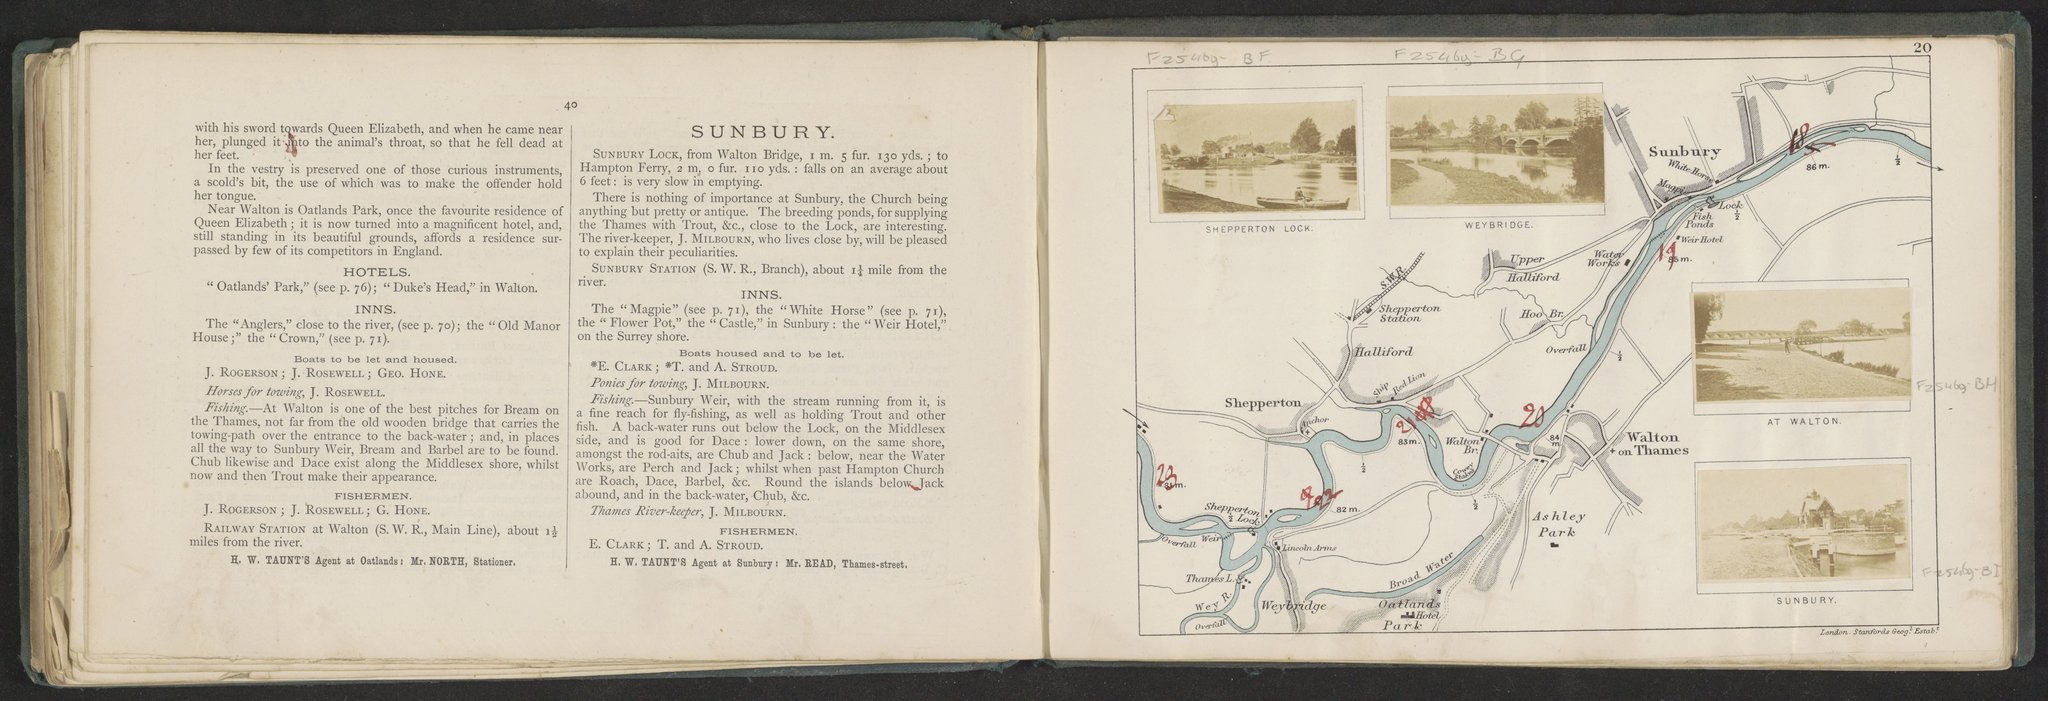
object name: page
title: At Walton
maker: henry w. taunt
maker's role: fotograaf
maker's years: 1842-1922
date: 1871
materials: photographic support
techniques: albumen print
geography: walton-on-thames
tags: river, bridge, thames